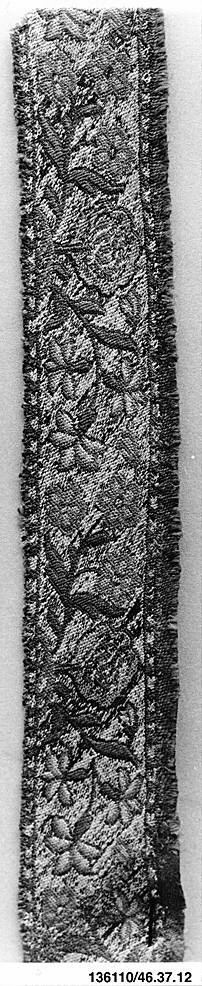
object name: strip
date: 1601-1700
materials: metal thread, silk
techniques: brocade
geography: iran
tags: flowers